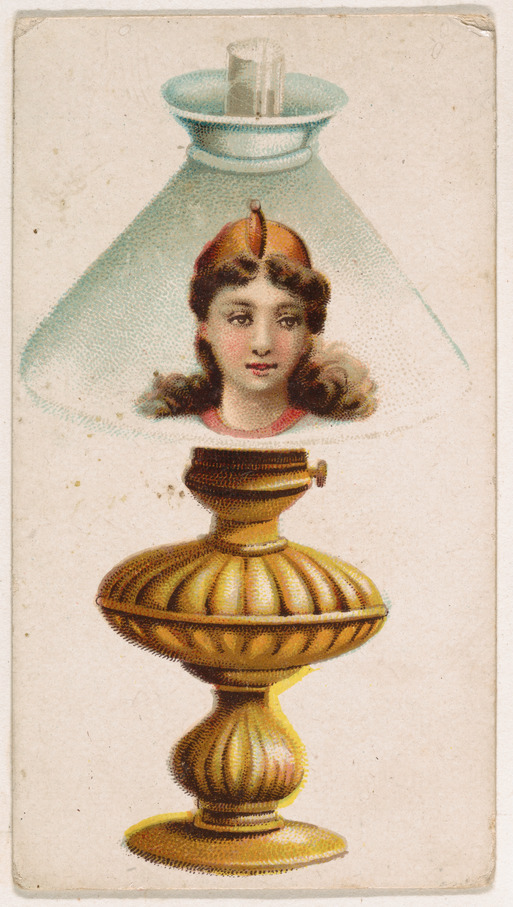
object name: print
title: Lamp, from the Novelties series (N228, Type 5) issued by Kinney Bros.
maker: kinney brothers tobacco company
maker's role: publisher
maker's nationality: american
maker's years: 1869-2011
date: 1889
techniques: color lithograph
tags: women,lamps